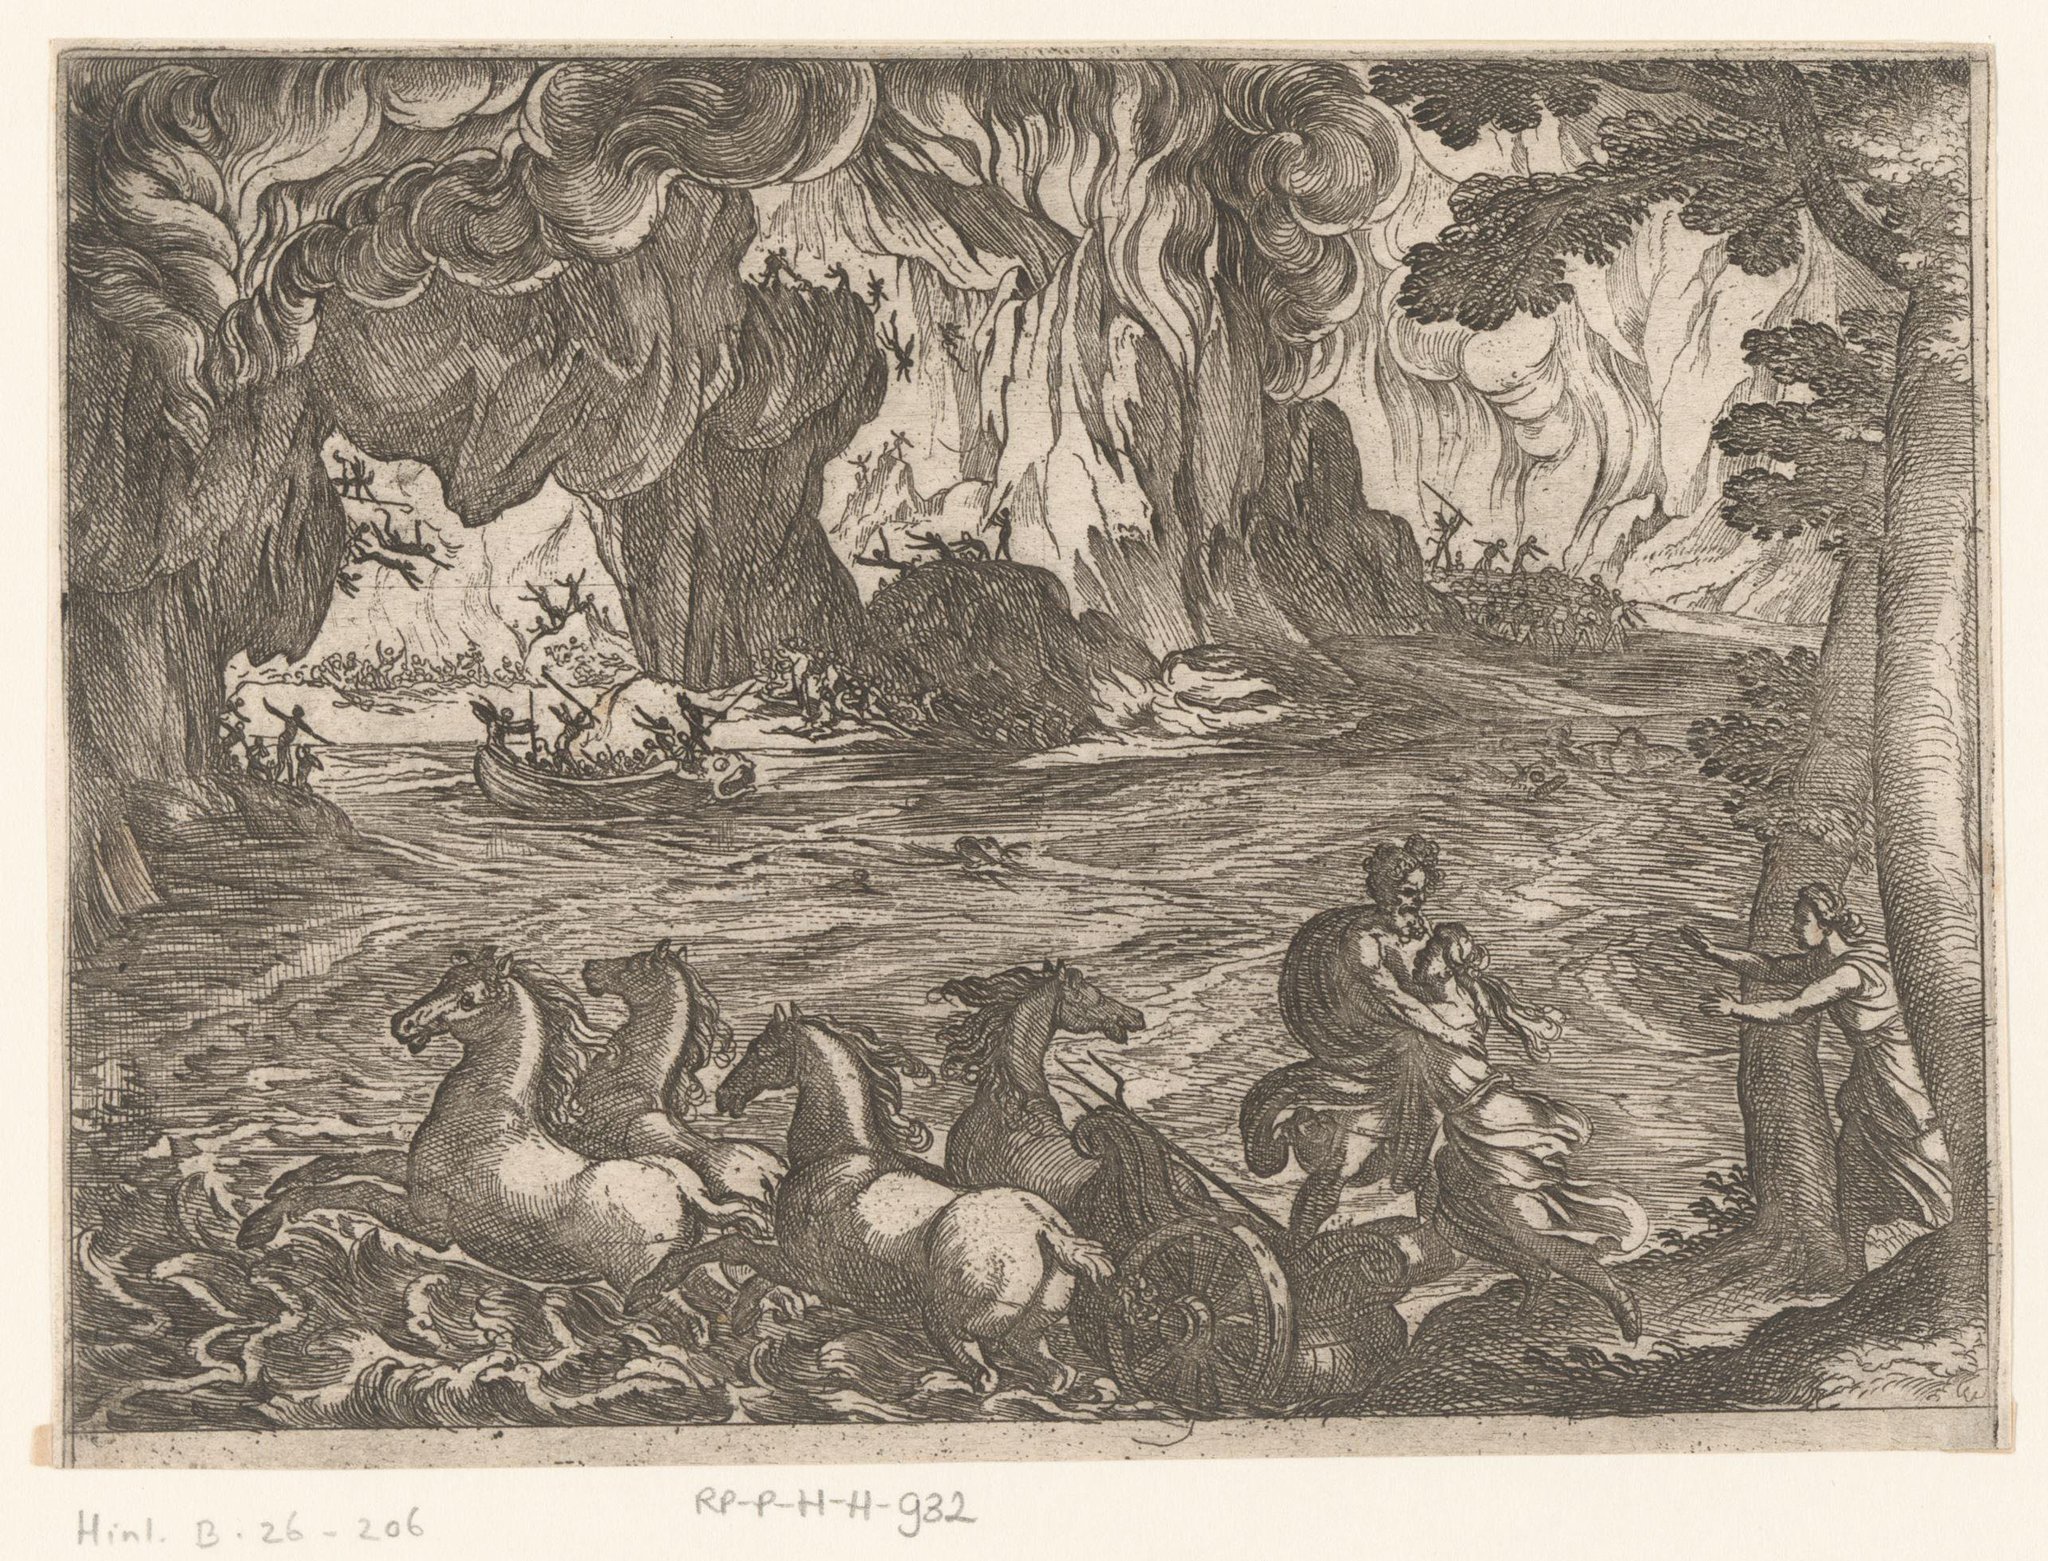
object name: print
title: Landschappen met mythologische scènes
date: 1565-1630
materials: paper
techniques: etching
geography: italy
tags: the rape of proserpina (by pluto in his chariot); possibly with diana and minerva trying to rescue her, landscapes - hh - ideal landscapes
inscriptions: collector's mark: ‘Hinloopen’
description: Proserpina, de dochter van de graangodin Ceres, wordt ontvoerd door Pluto, de koning van de onderwereld. Hij tilt haar in zijn rijtuig dat wordt voortgetrokken door vier paarden die richting de Hades rijden.